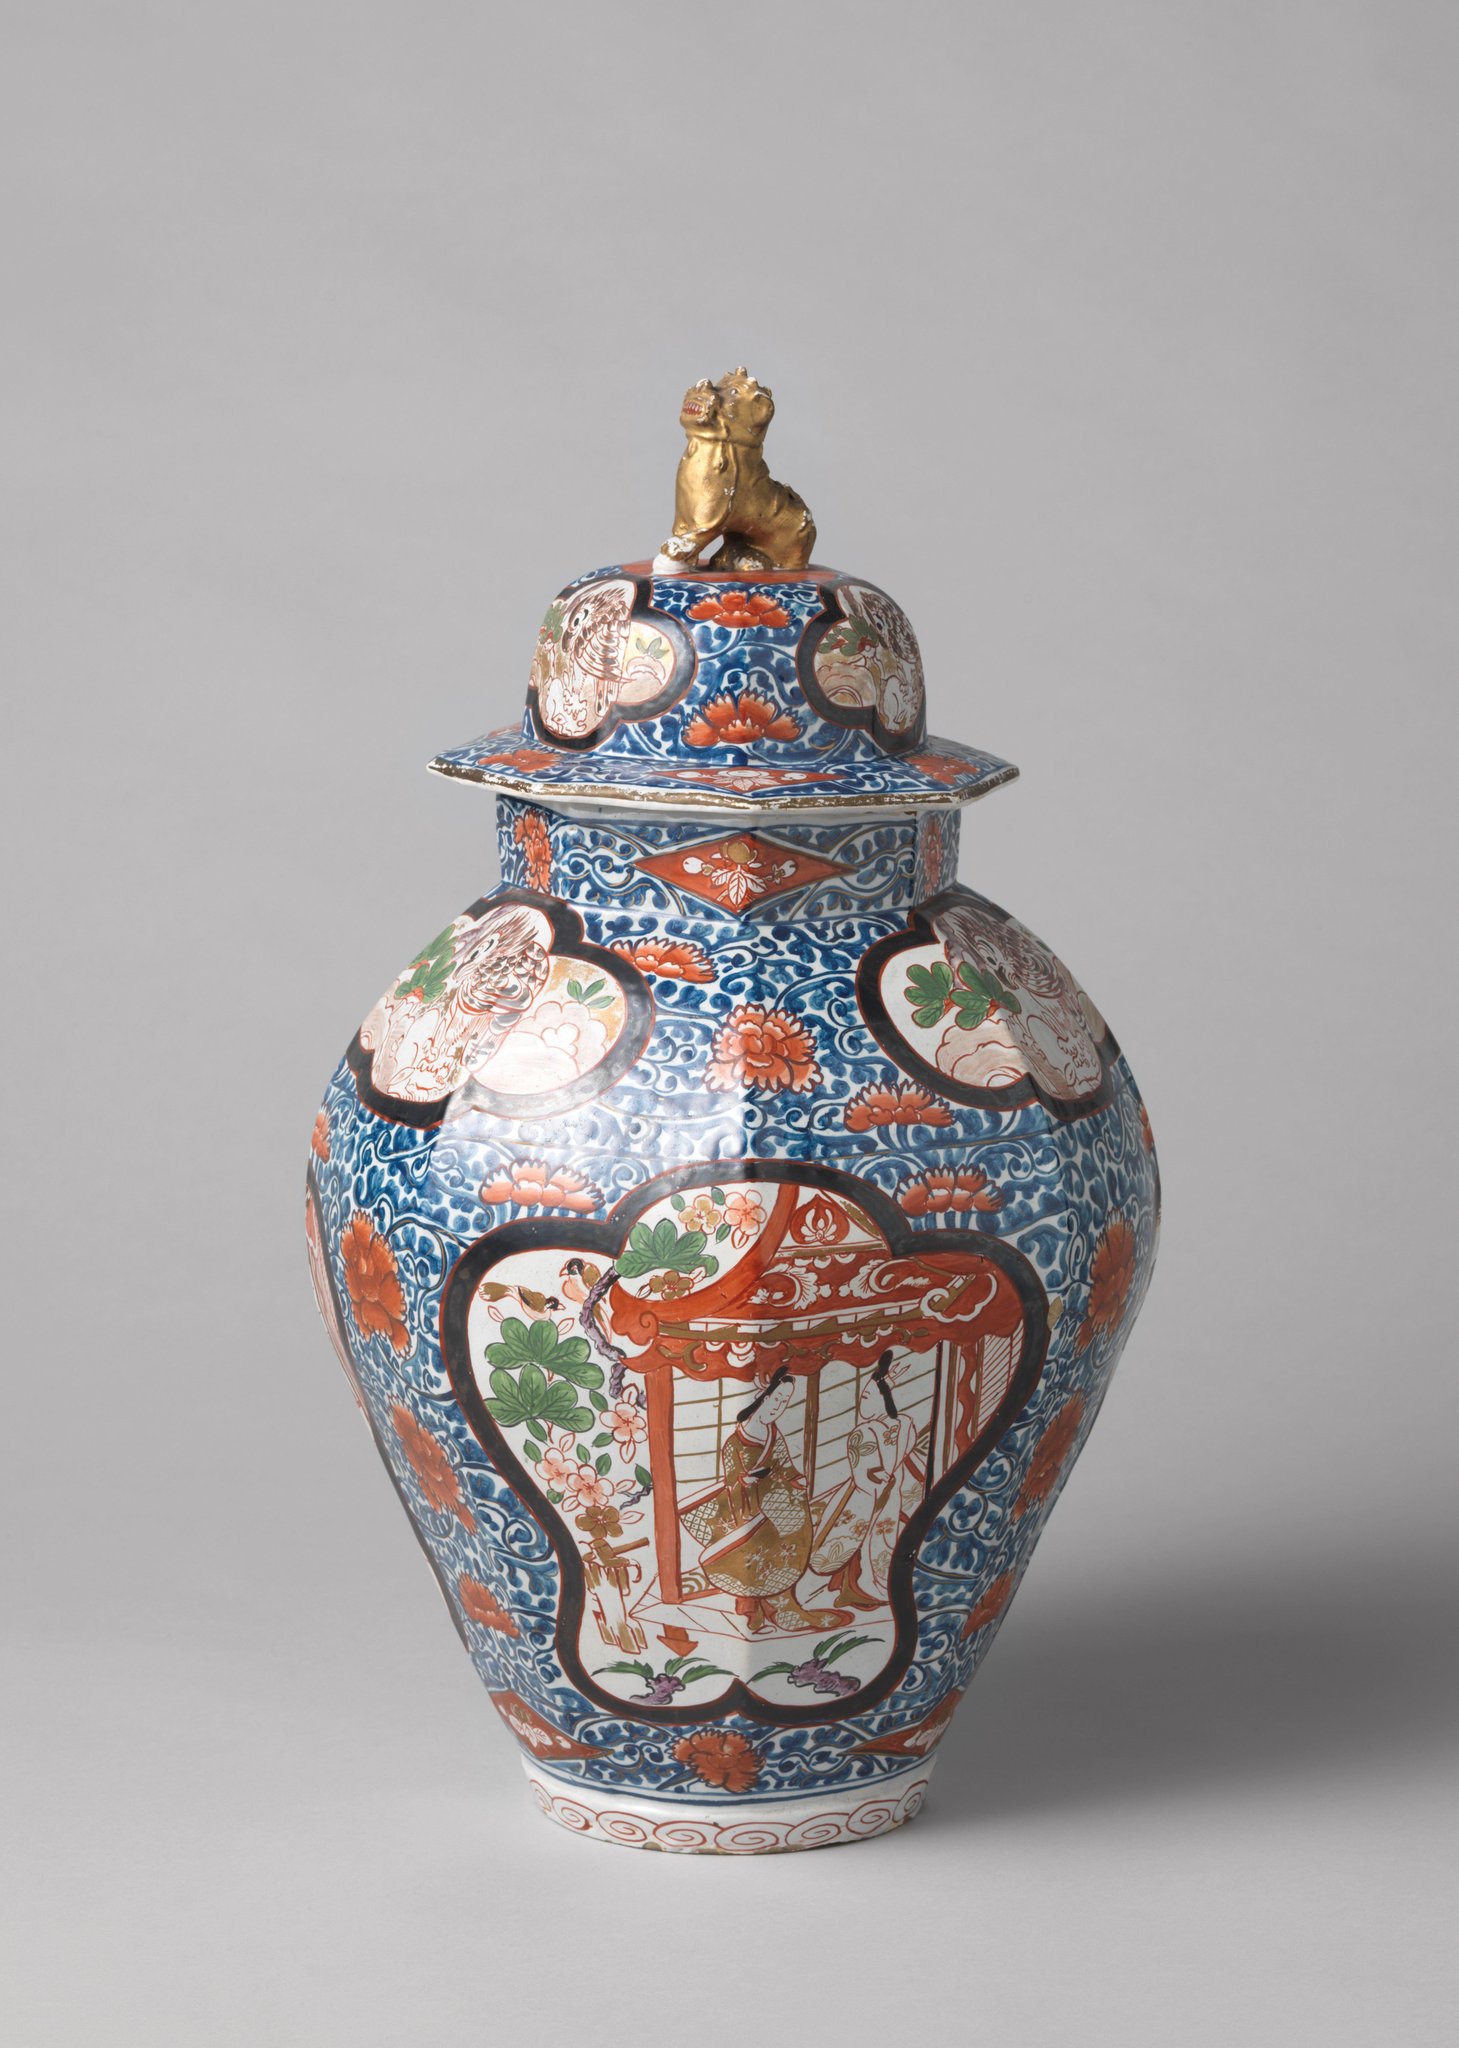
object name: covered jar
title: Dekselpot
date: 1830-1850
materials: faience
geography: delft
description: Dekselpot van faience. Veelkleurig beschilderd met Japans Imari decor. De dekselpot is onderdeel van een kaststel.